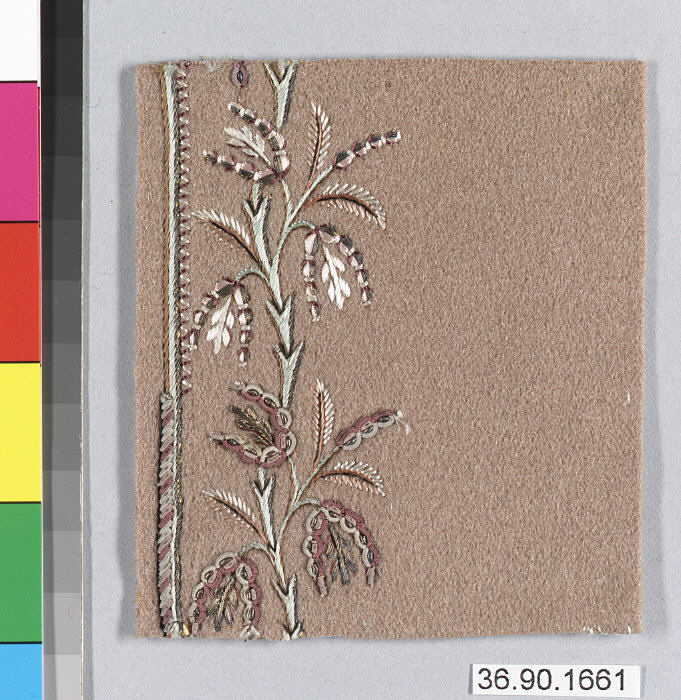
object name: sample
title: Embroidery sample for a man’s suit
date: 1785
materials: metal thread, silk, wool